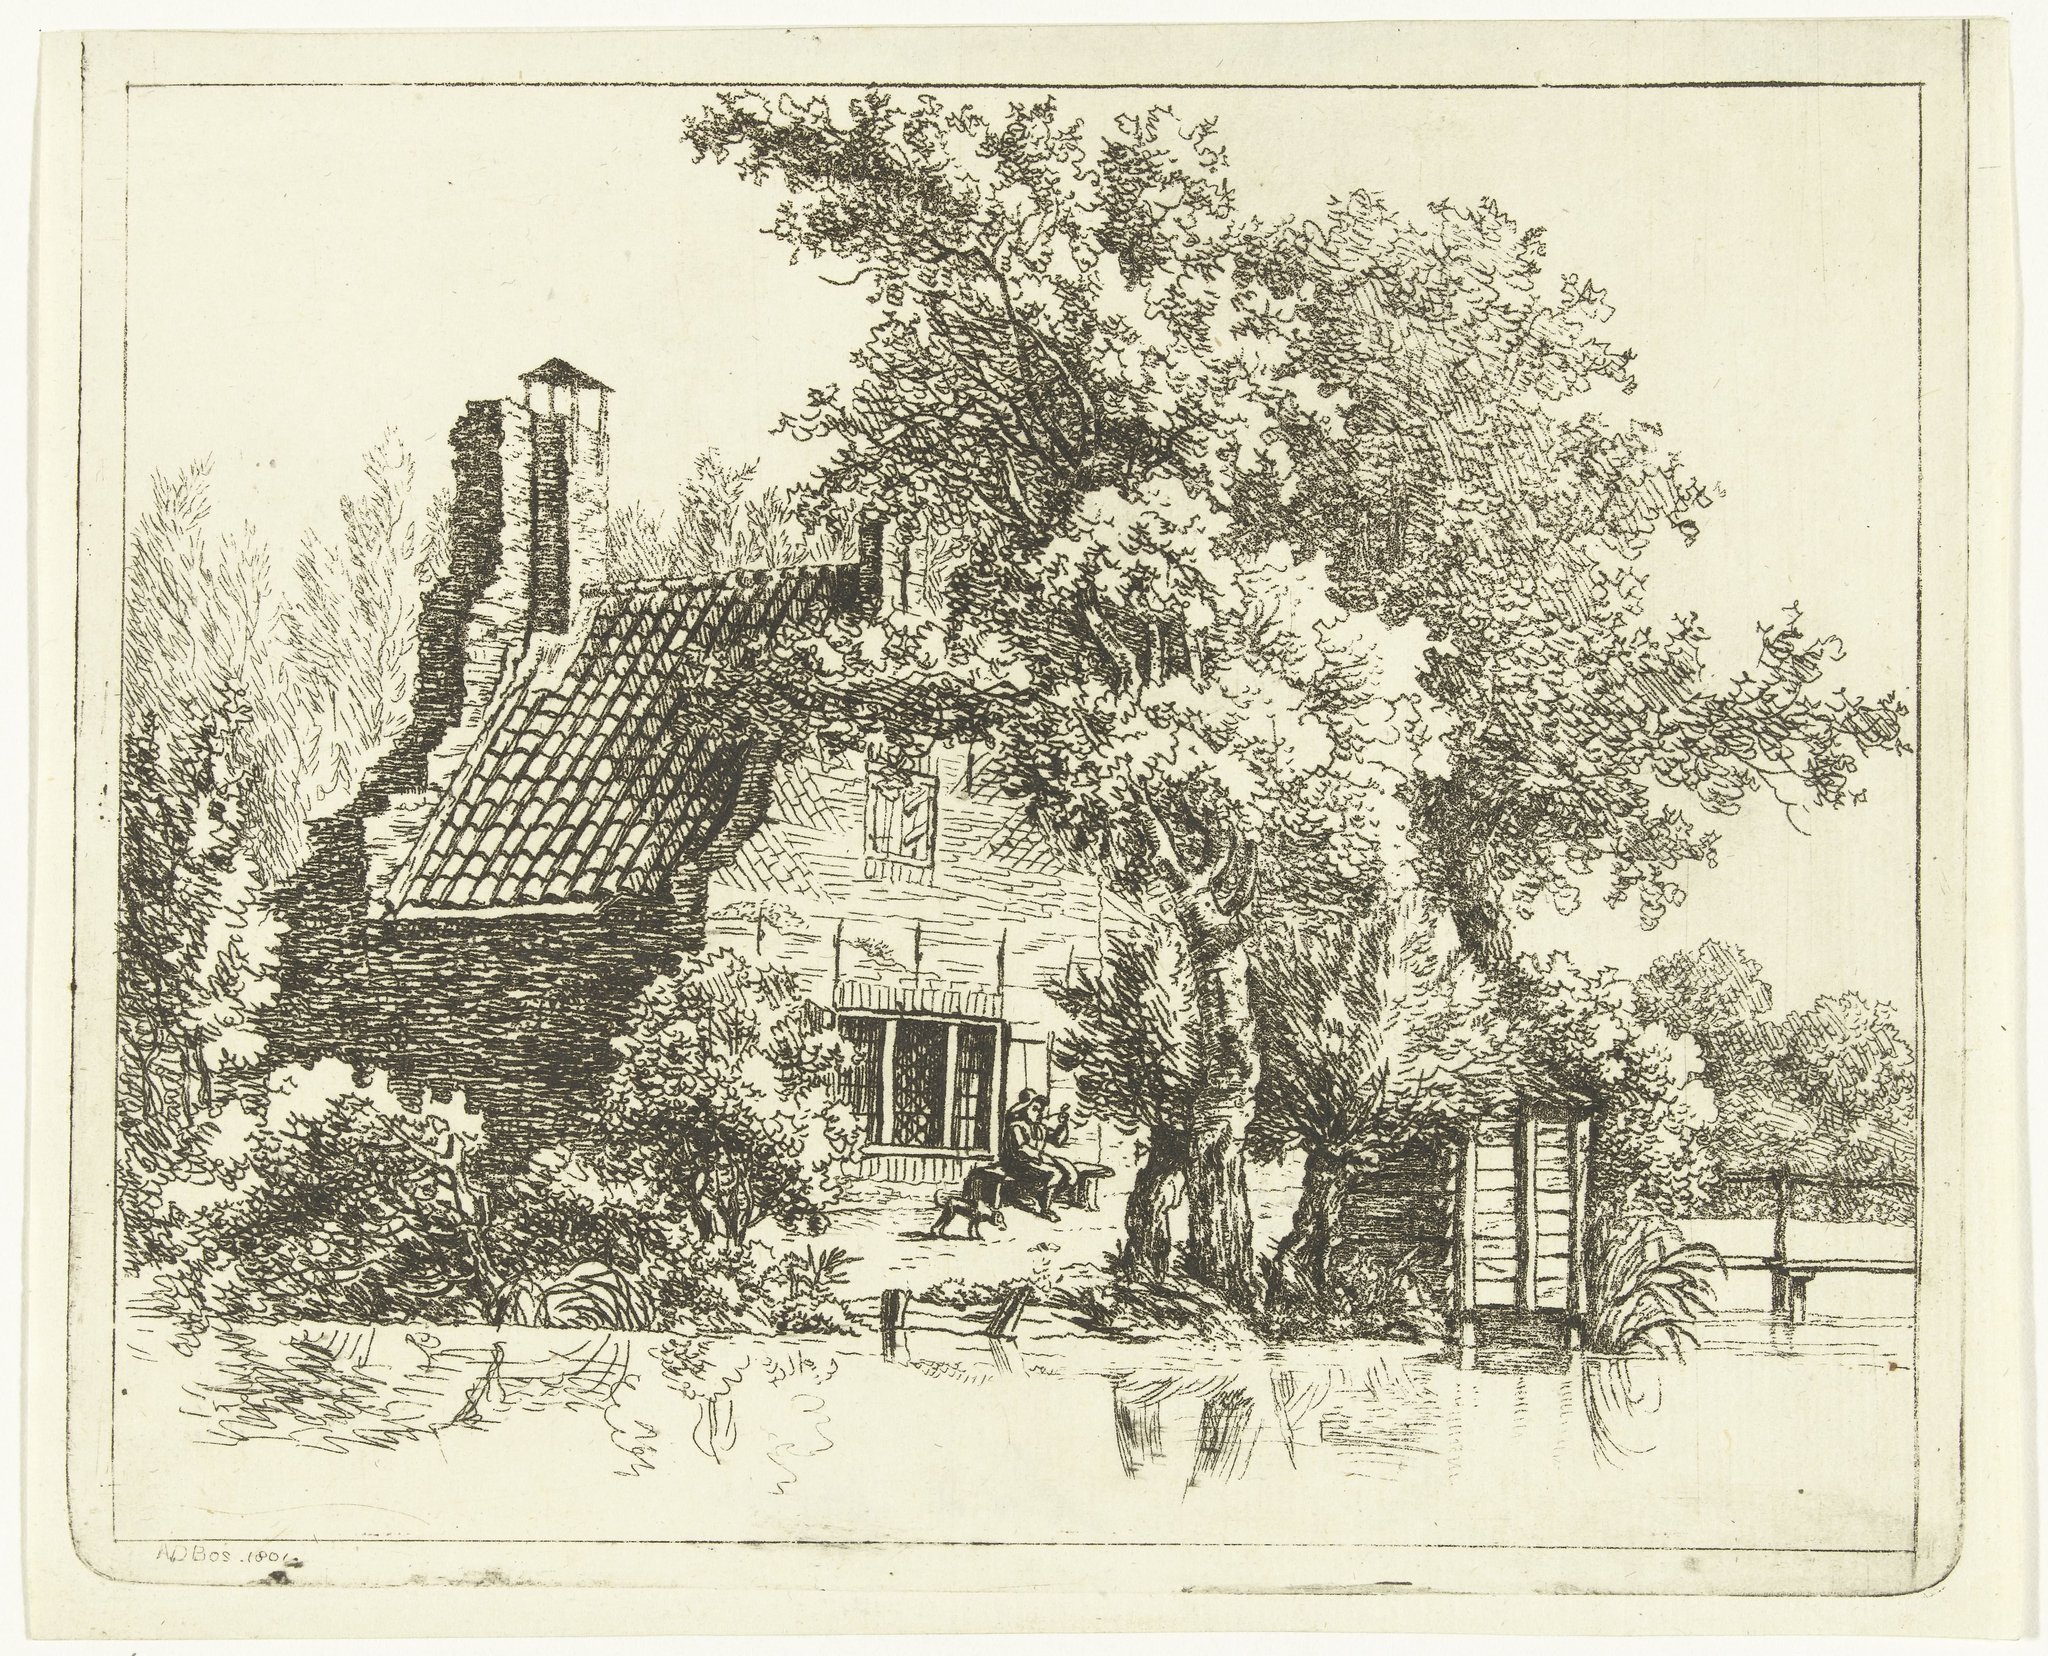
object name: print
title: Rokende man op een bankje voor de ruïne van het Huis Snaatburg te Maarssen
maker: anthonie van den bos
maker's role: draughtsman, print maker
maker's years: 1763-1838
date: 1801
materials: paper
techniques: etching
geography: netherlands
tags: ruin of a dwelling, house, castle, etc.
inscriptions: collector's mark: Lugt 2228